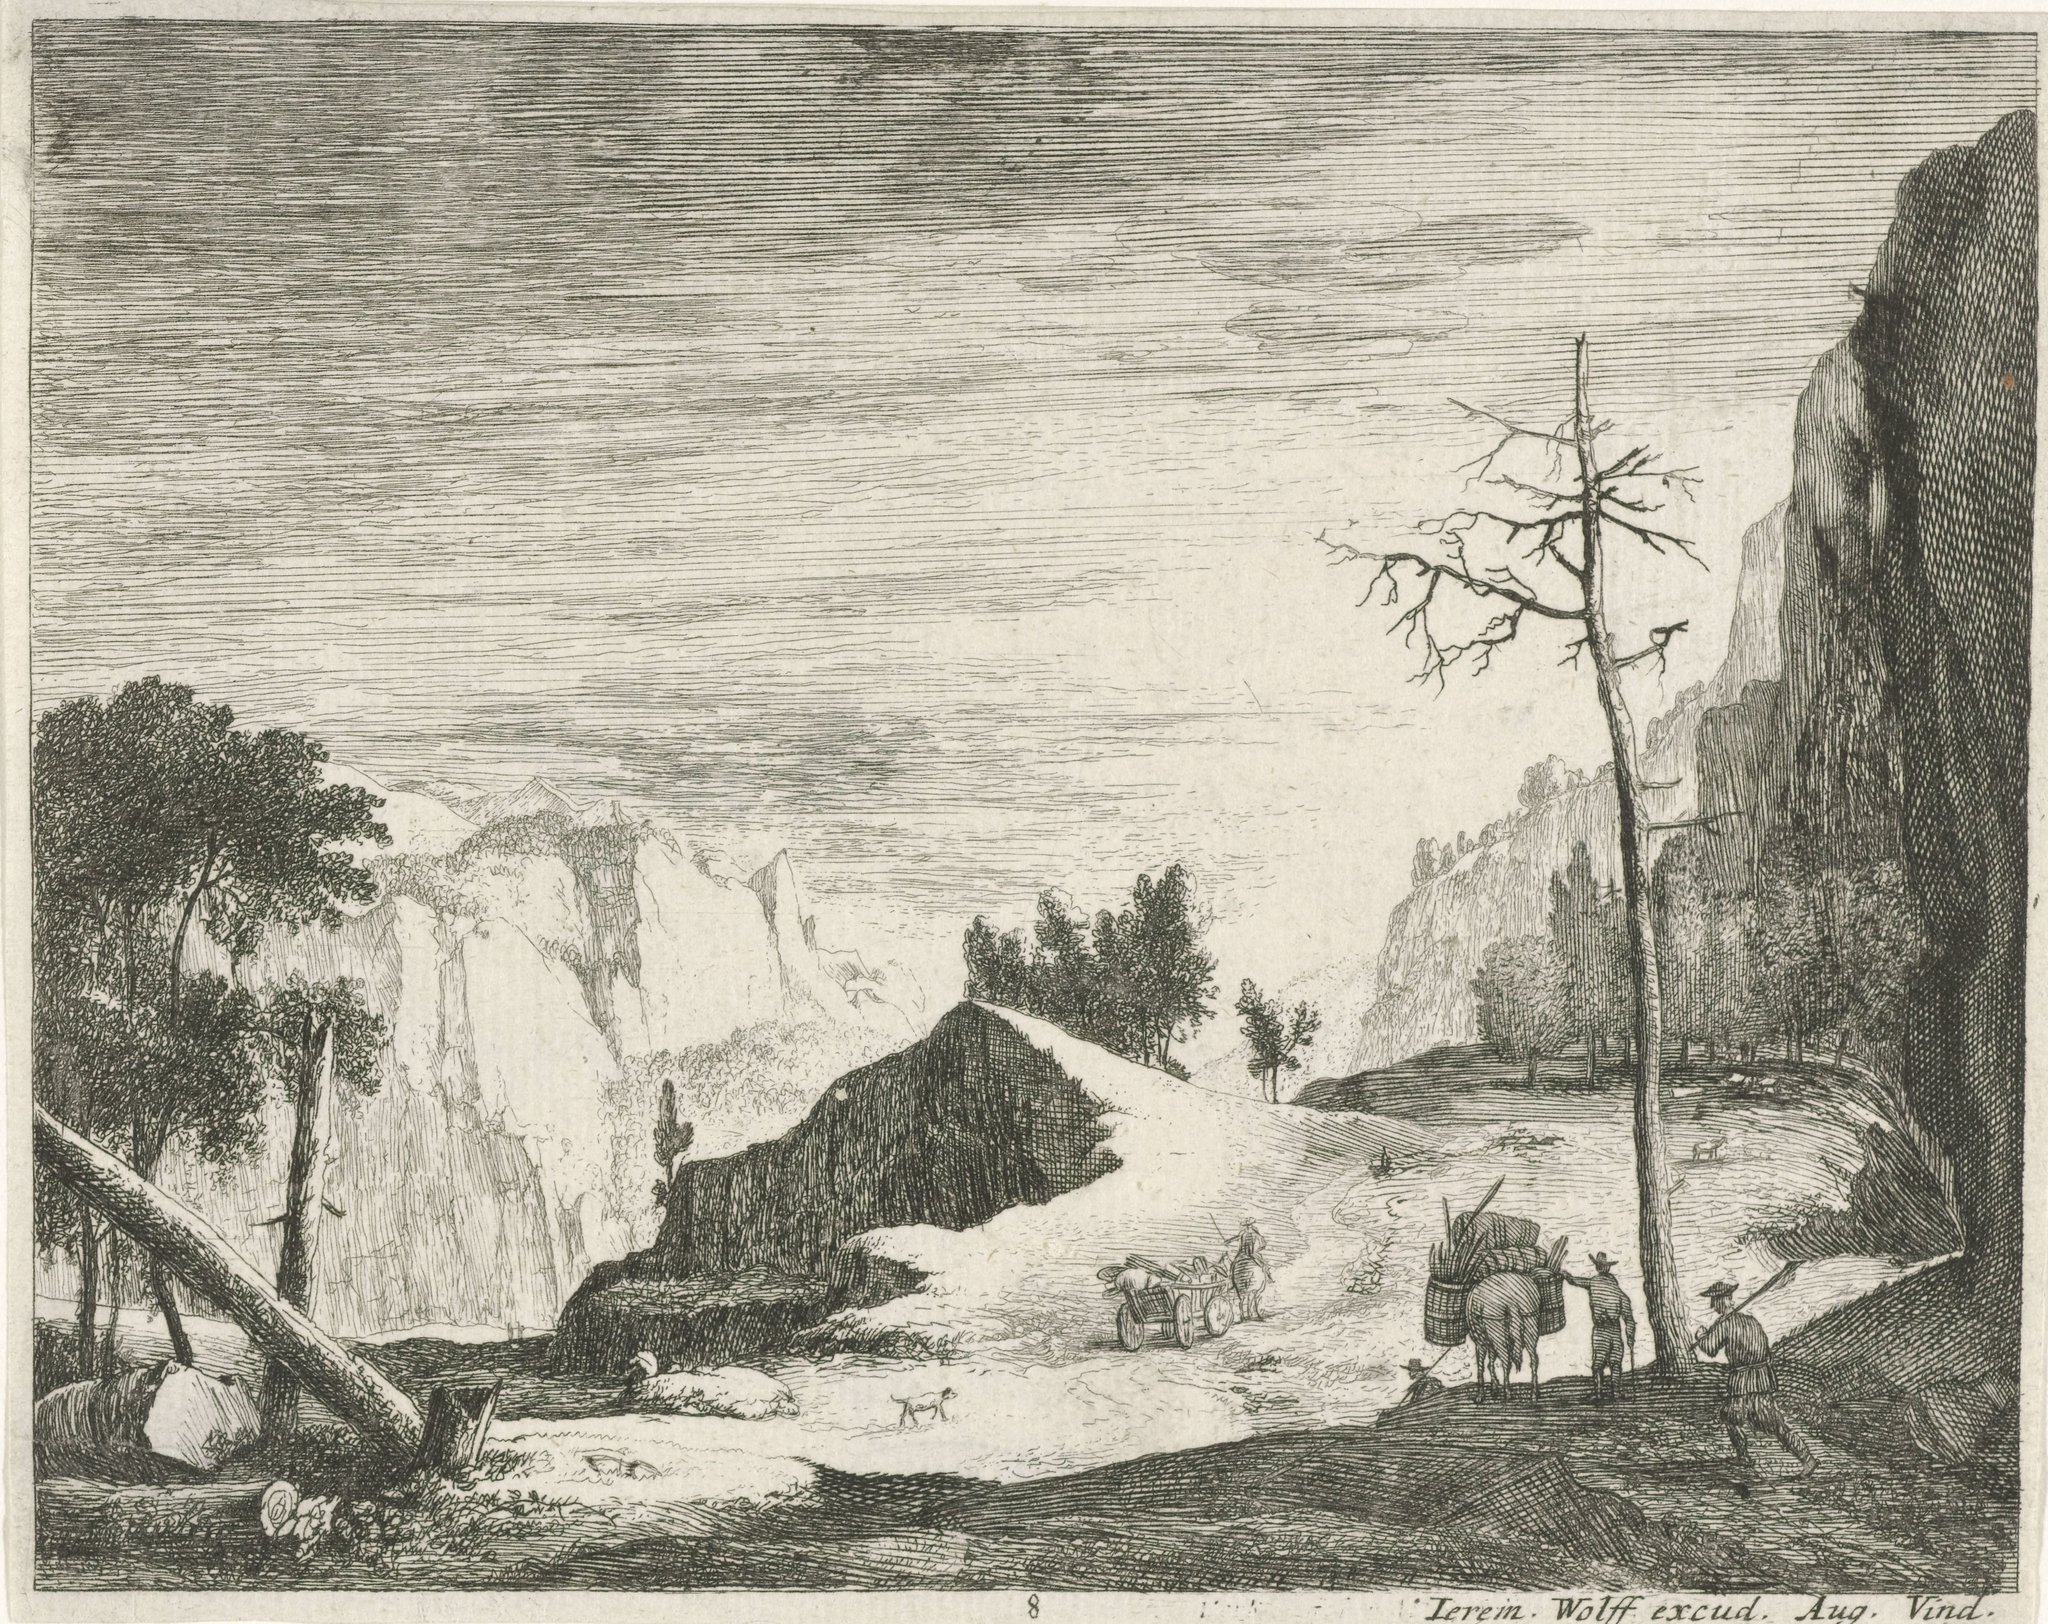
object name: print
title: Tiroolse landschappen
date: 1673-1724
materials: paper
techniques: etching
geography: amsterdam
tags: animal traction, animal-drawn vehicle (carriage etc.), public road, dog, mountains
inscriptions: collector's mark: Lugt 2228a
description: Gezicht op een weg in een berglandschap. Over de weg vervoeren figuren goederen per ezel en per kar. Prent uit een serie van acht prenten met Tiroolse landschappen.